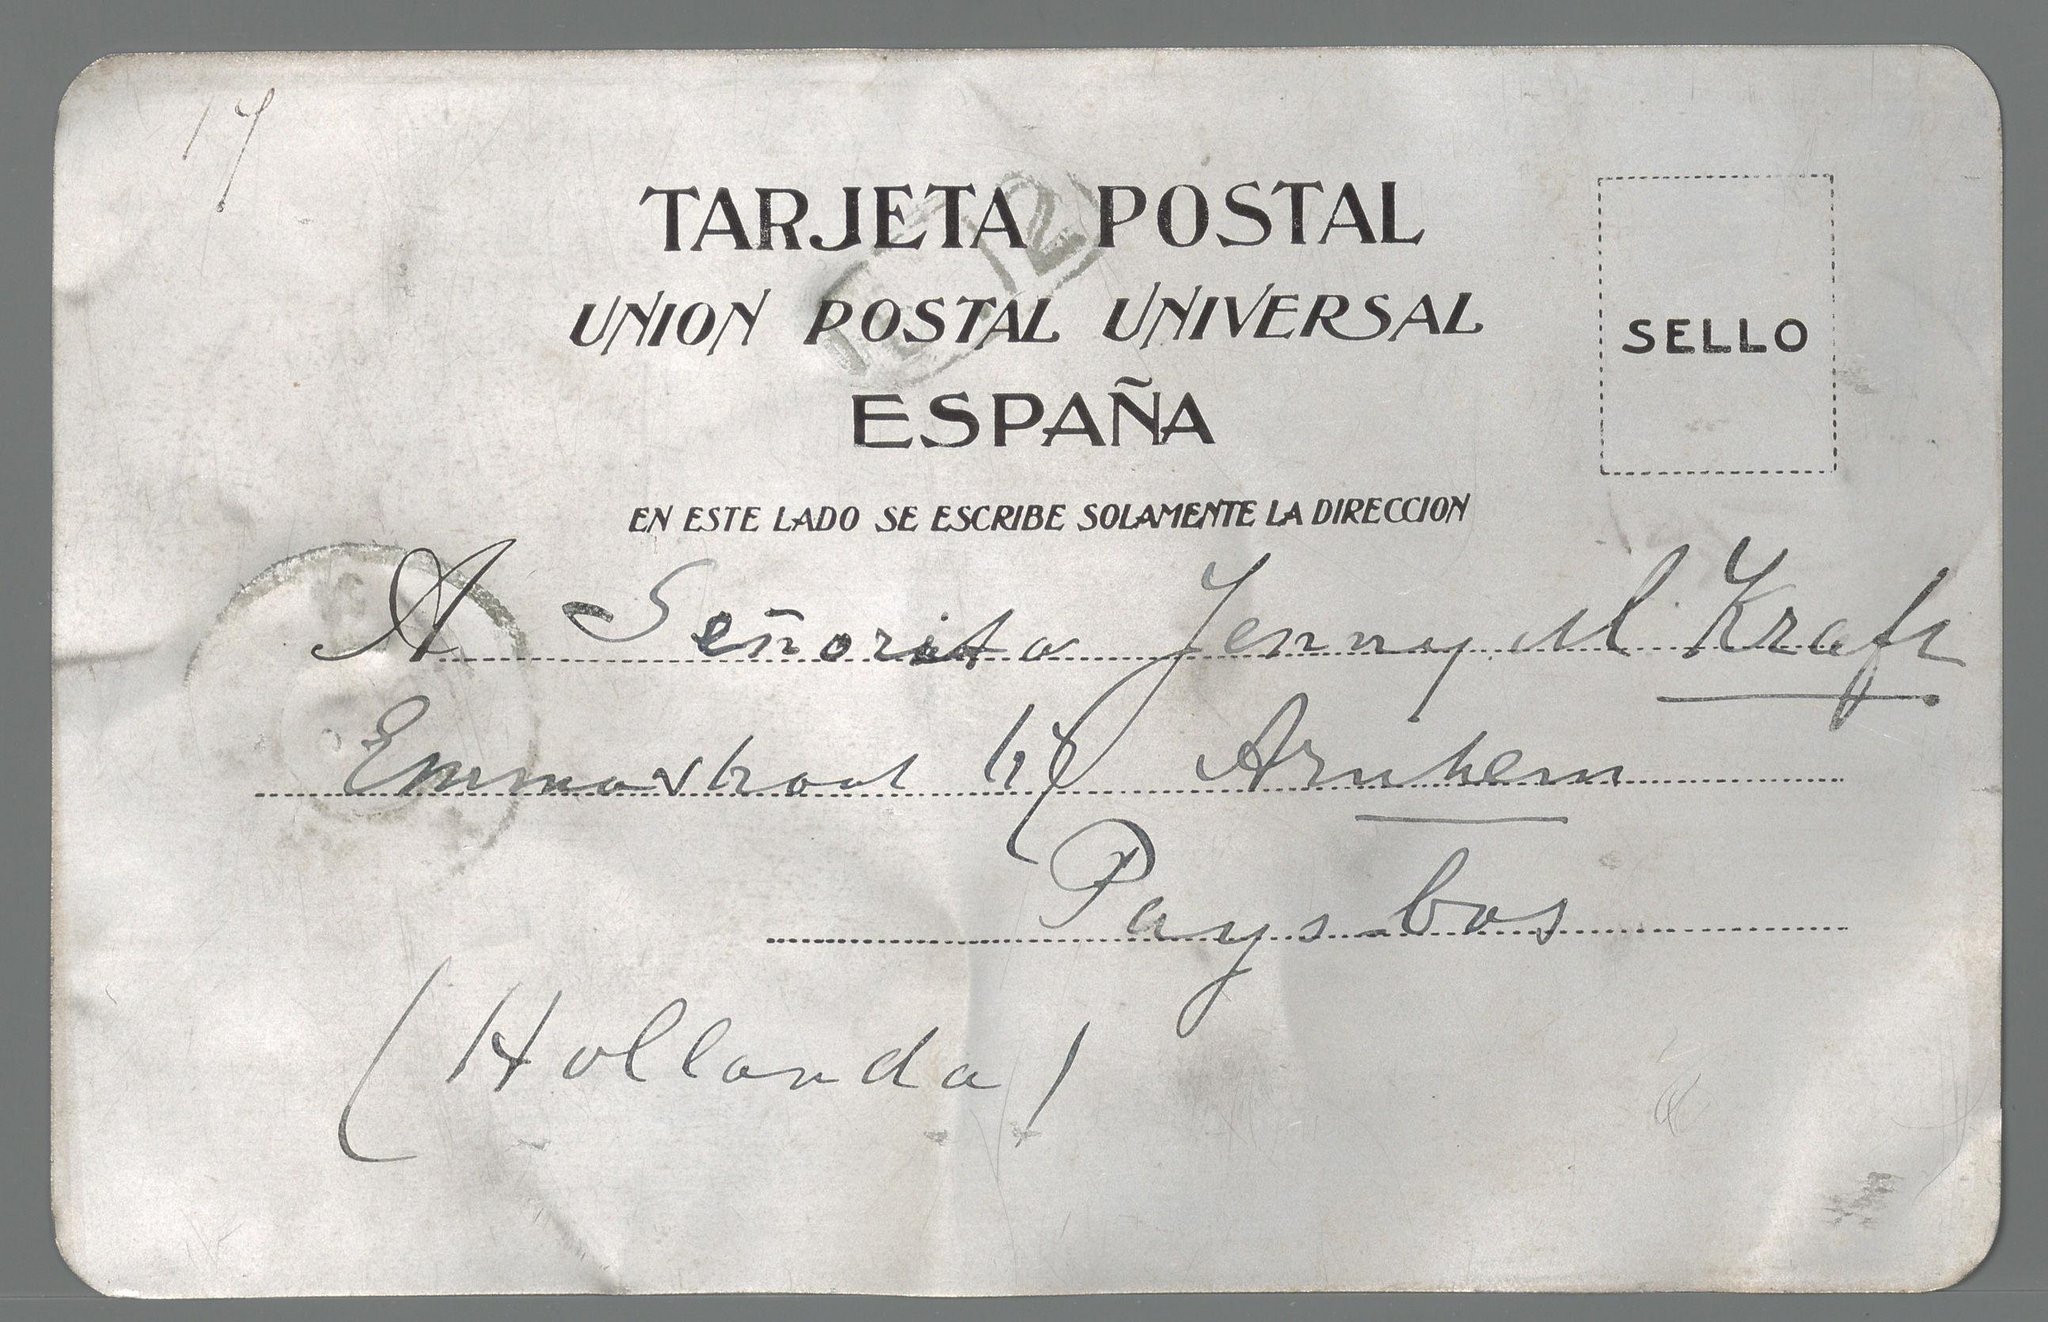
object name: ansichtkaart, prentbriefkaart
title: Sevilla - Alcazar - Salon de Embajadores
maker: Anonymous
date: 1890-1906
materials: aluminum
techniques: autotype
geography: sevilla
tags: palace - aa - civic architecture: inside